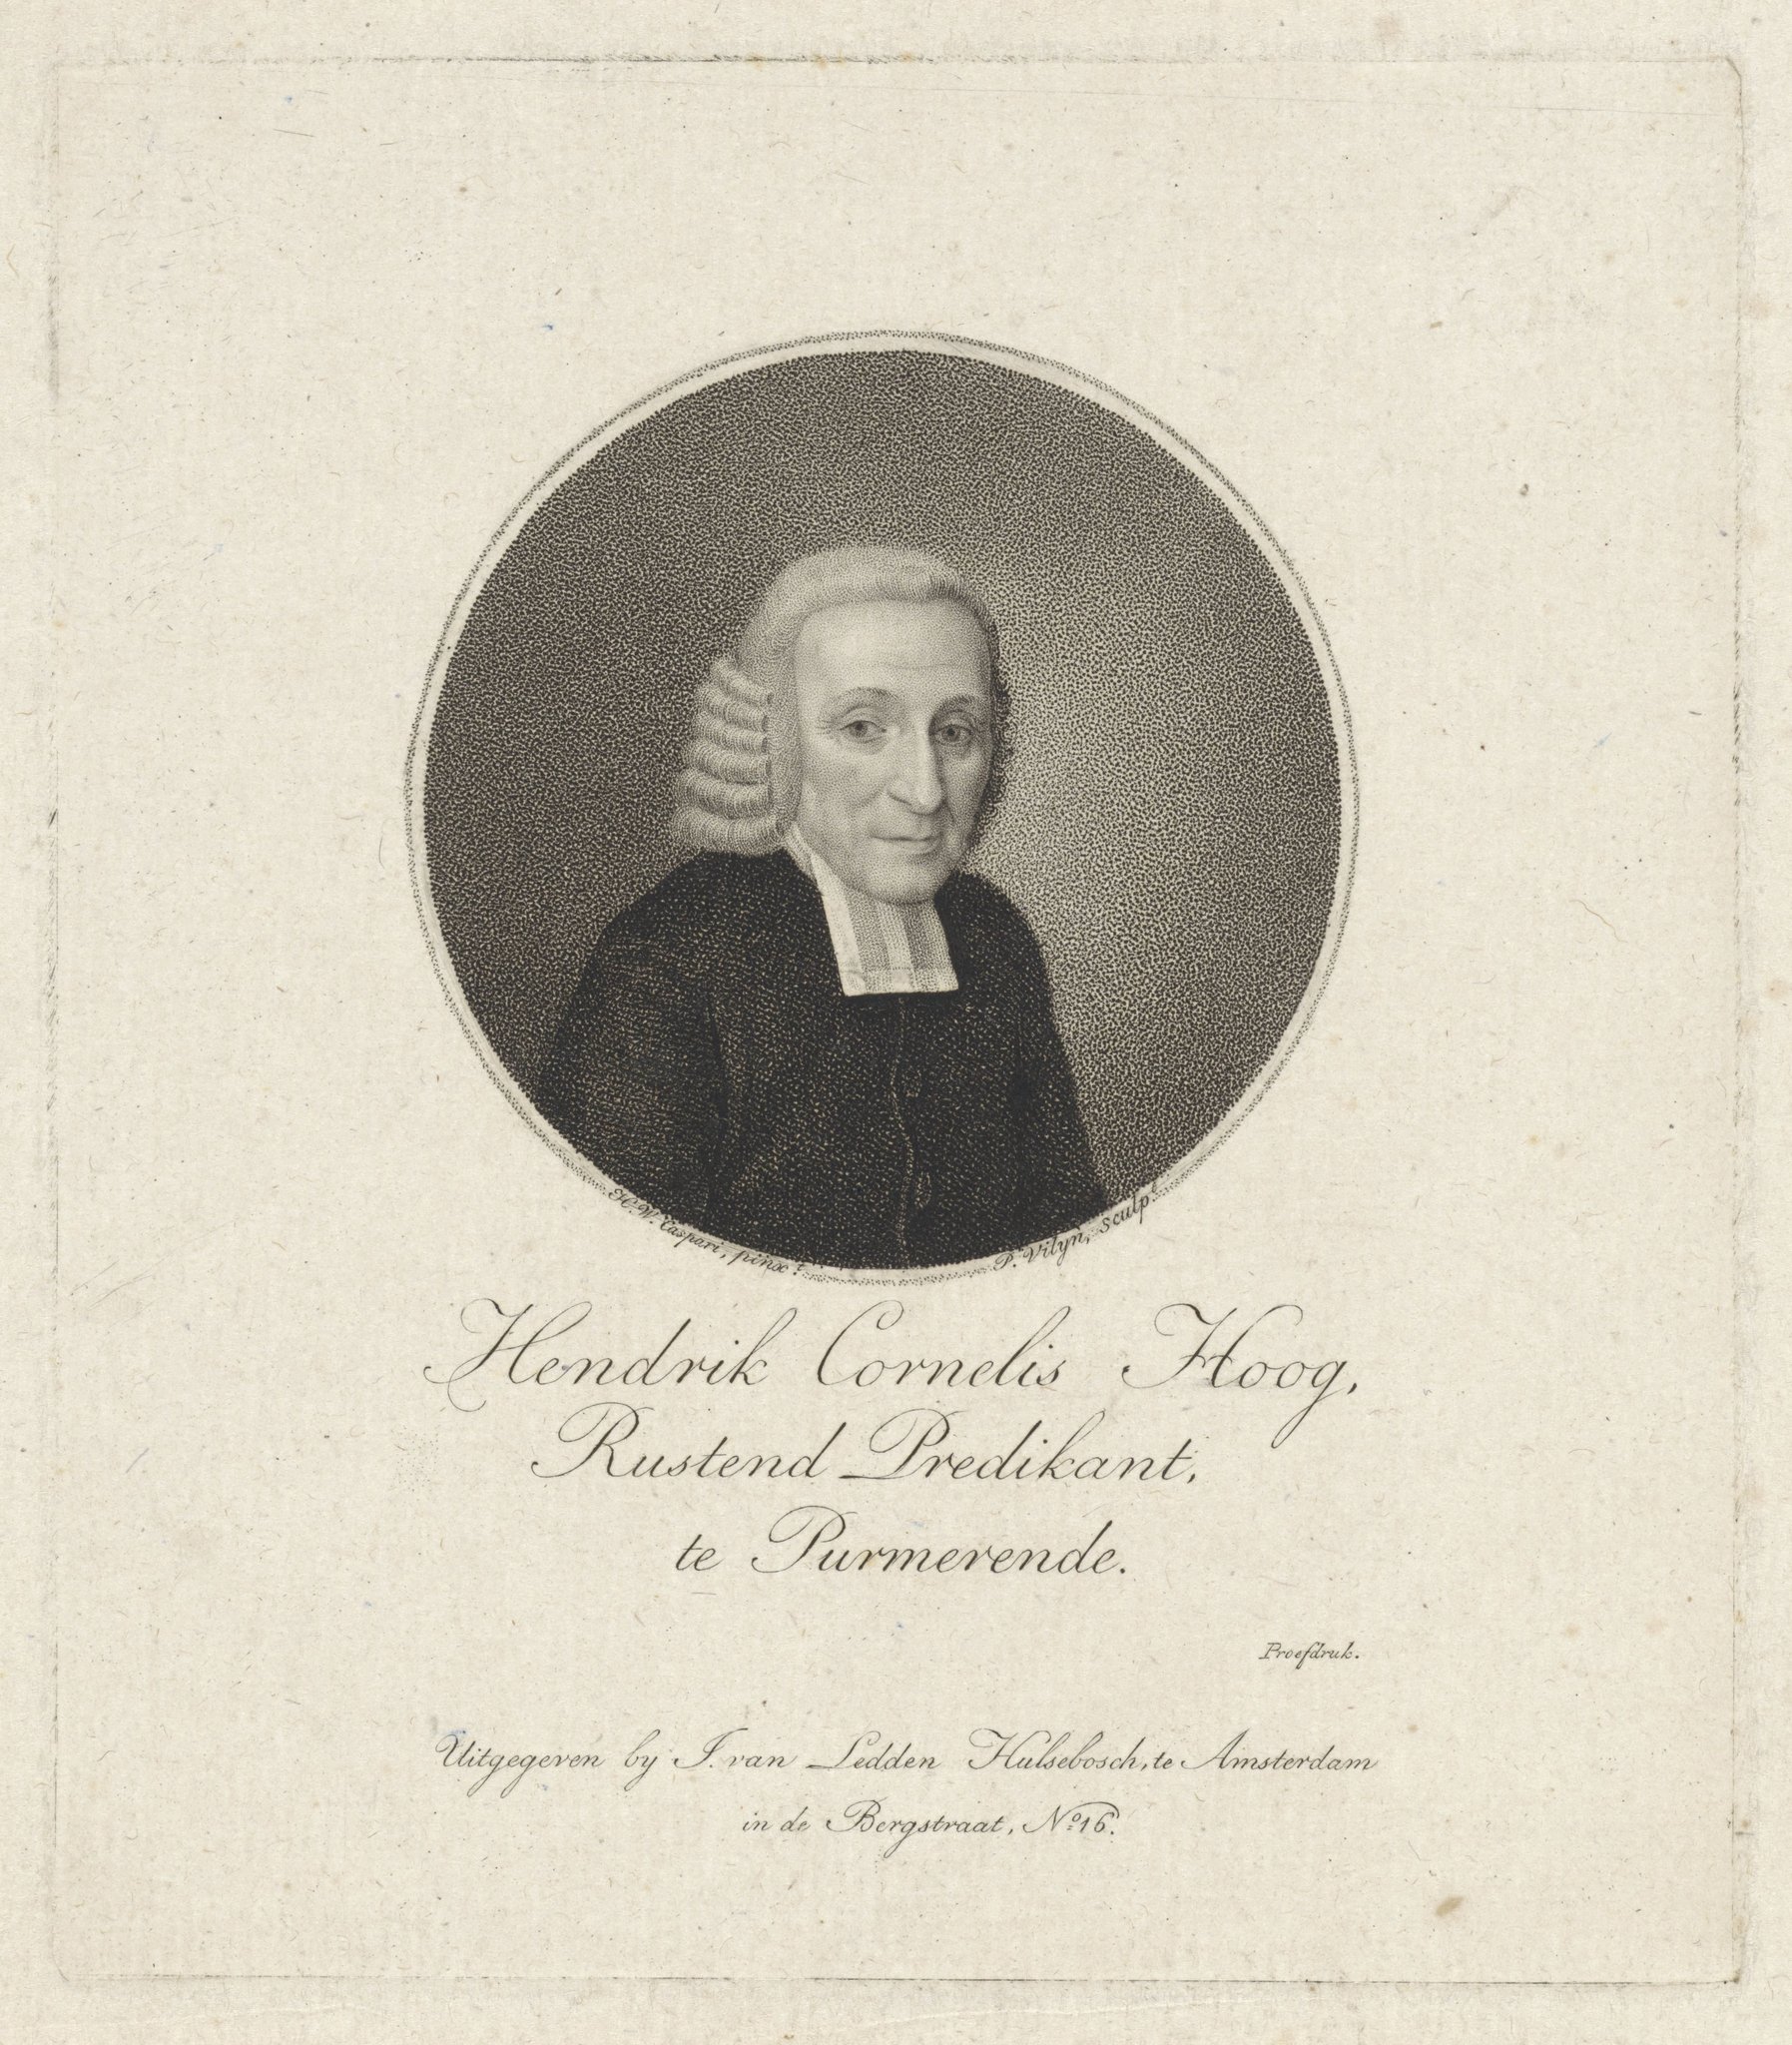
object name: print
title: Portret van Hendrik Cornelis Hoog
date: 1787-1836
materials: paper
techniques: stippled etching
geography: amsterdam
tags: predikant, hendrik cornelis hoog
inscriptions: collector's mark: Lugt 2228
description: Portret van Hendrik Cornelis Hoog, hervormd predikant te Purmerend.